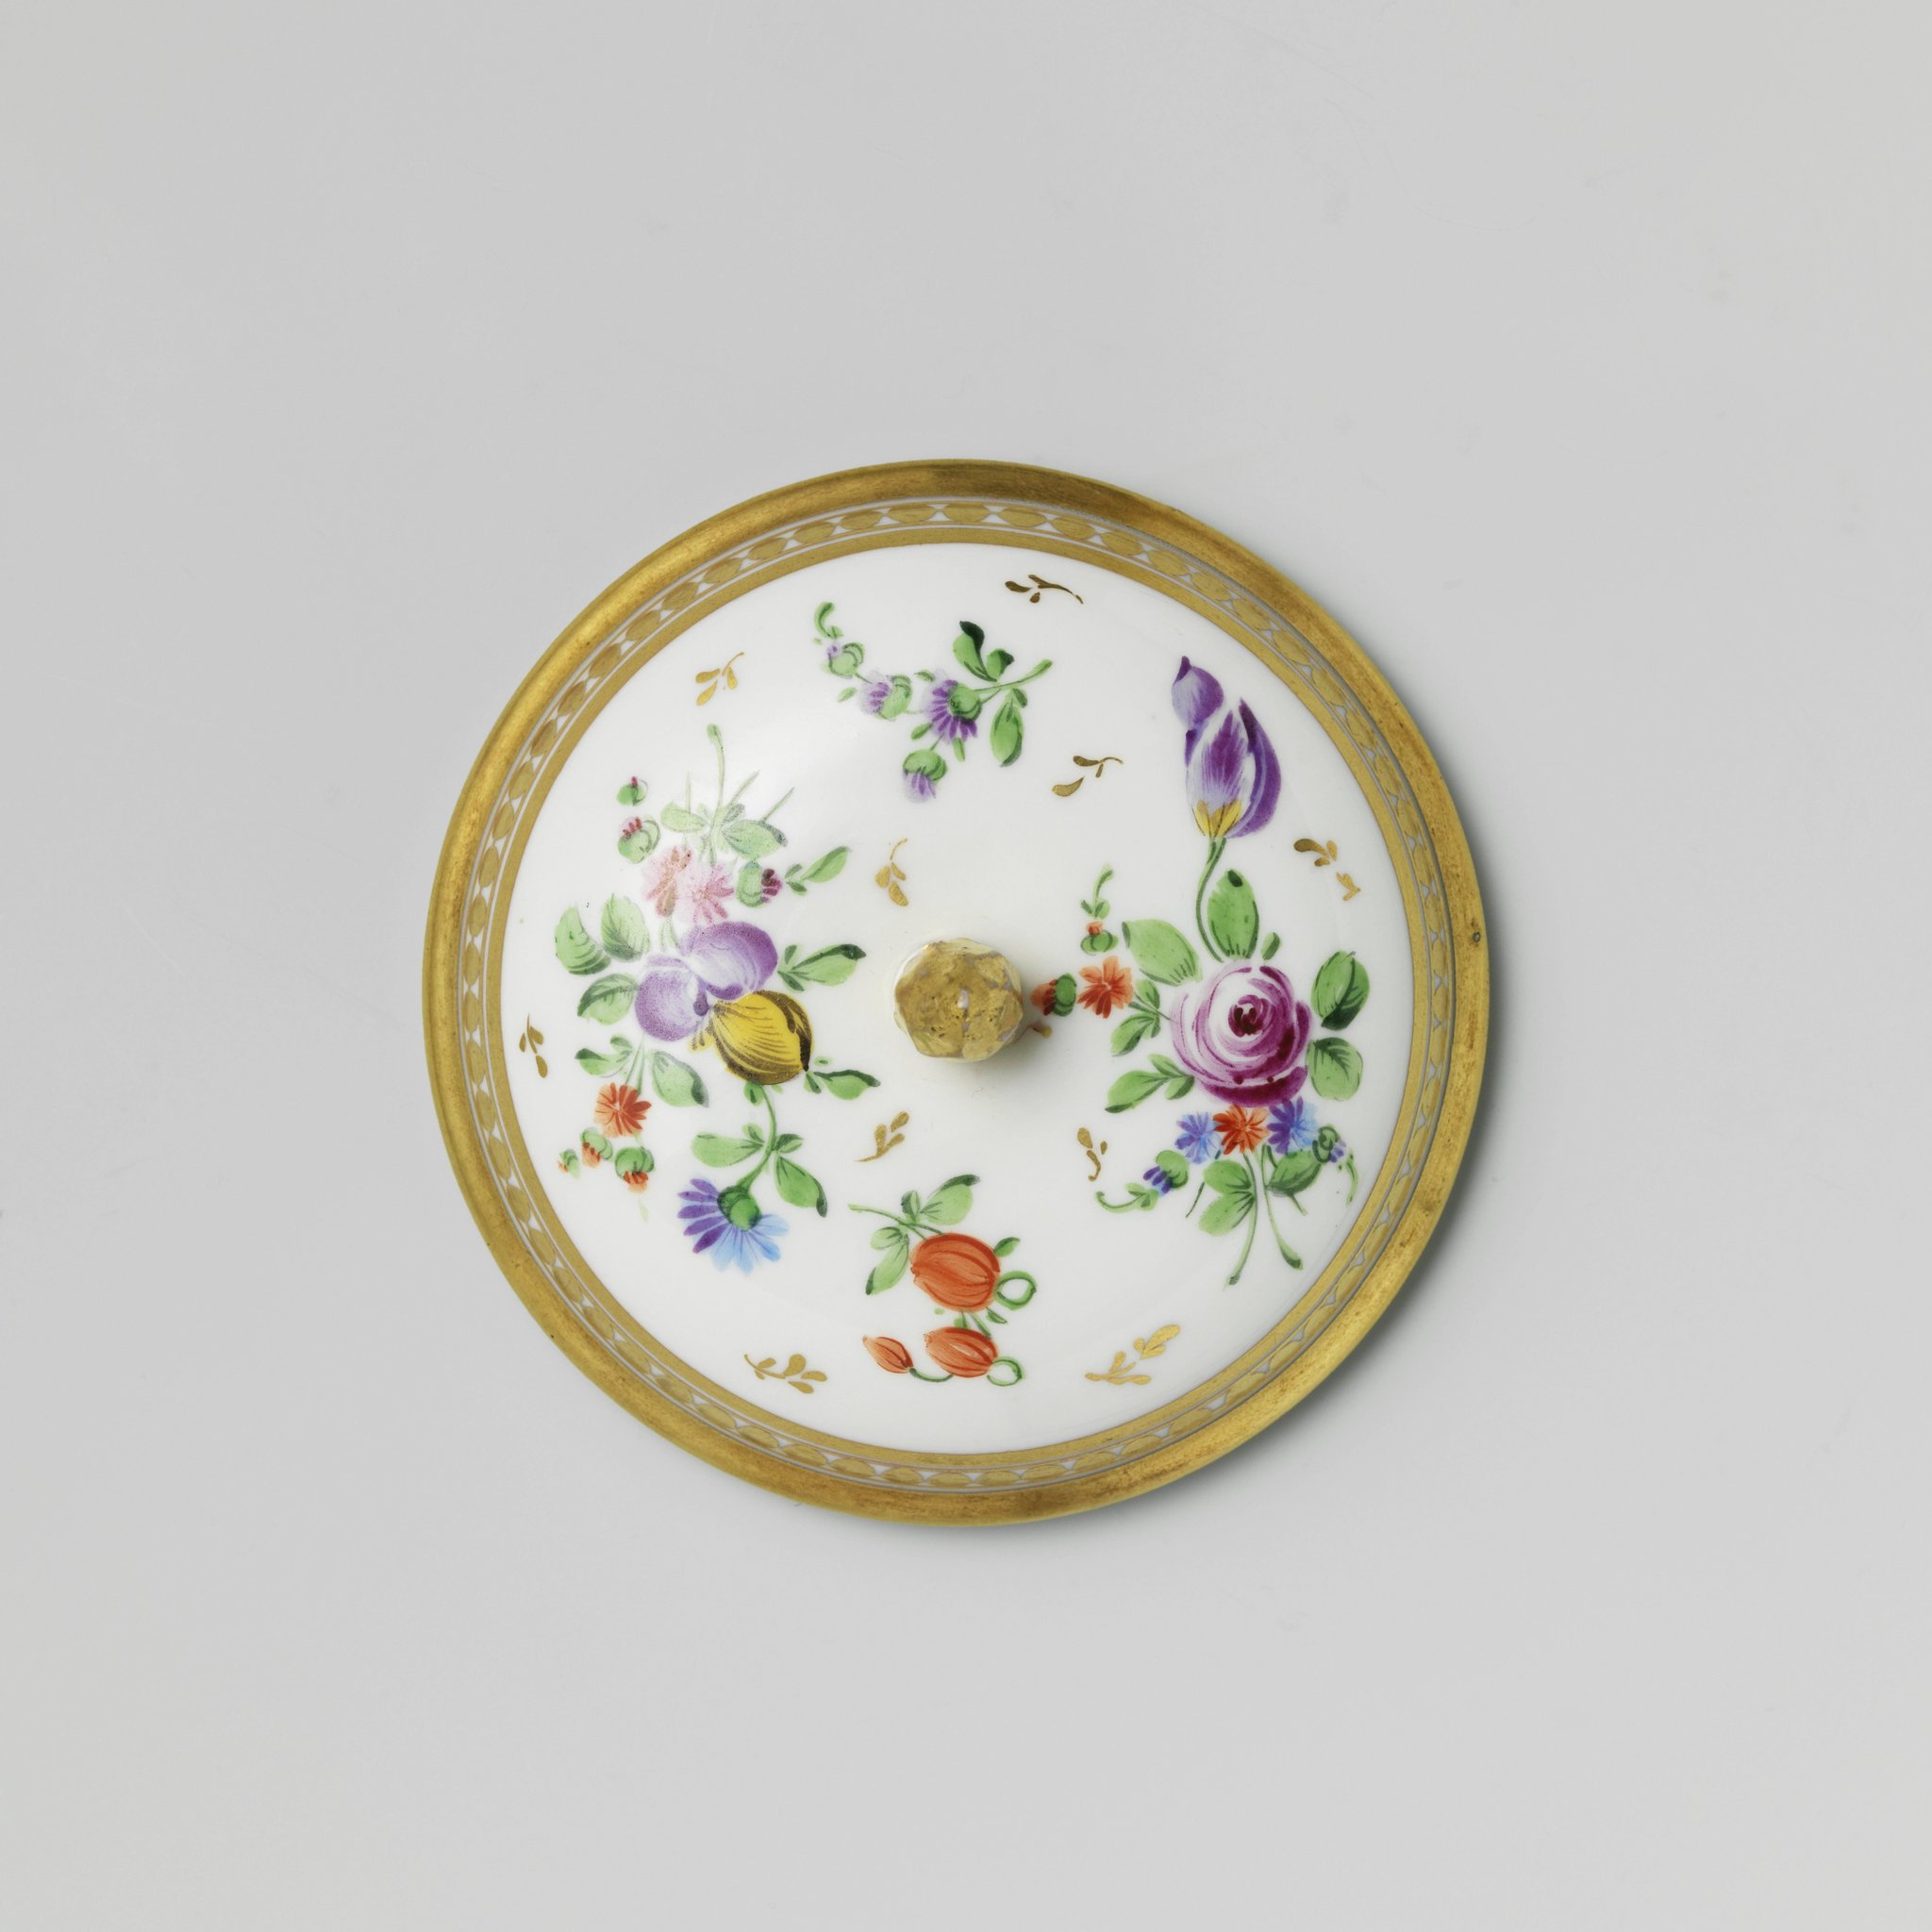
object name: cup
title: Cover with bouquets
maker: Anonymous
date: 1800-1899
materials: glaze, gold, paint, porcelain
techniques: firing, forming, gilding, turning, vitrification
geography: france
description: Rond, gewelfd deksel van veelkleurig beschilderd porselein. Het deksel heeft een vlamvormige knop. Op het deksel zijn bloemboeketten geschilderd en langs de rand een gouden bies. Het deksel hoort bij een vals gemerkte kop (BK-1977-258-B) en een schotel (BK-1977-258-A).